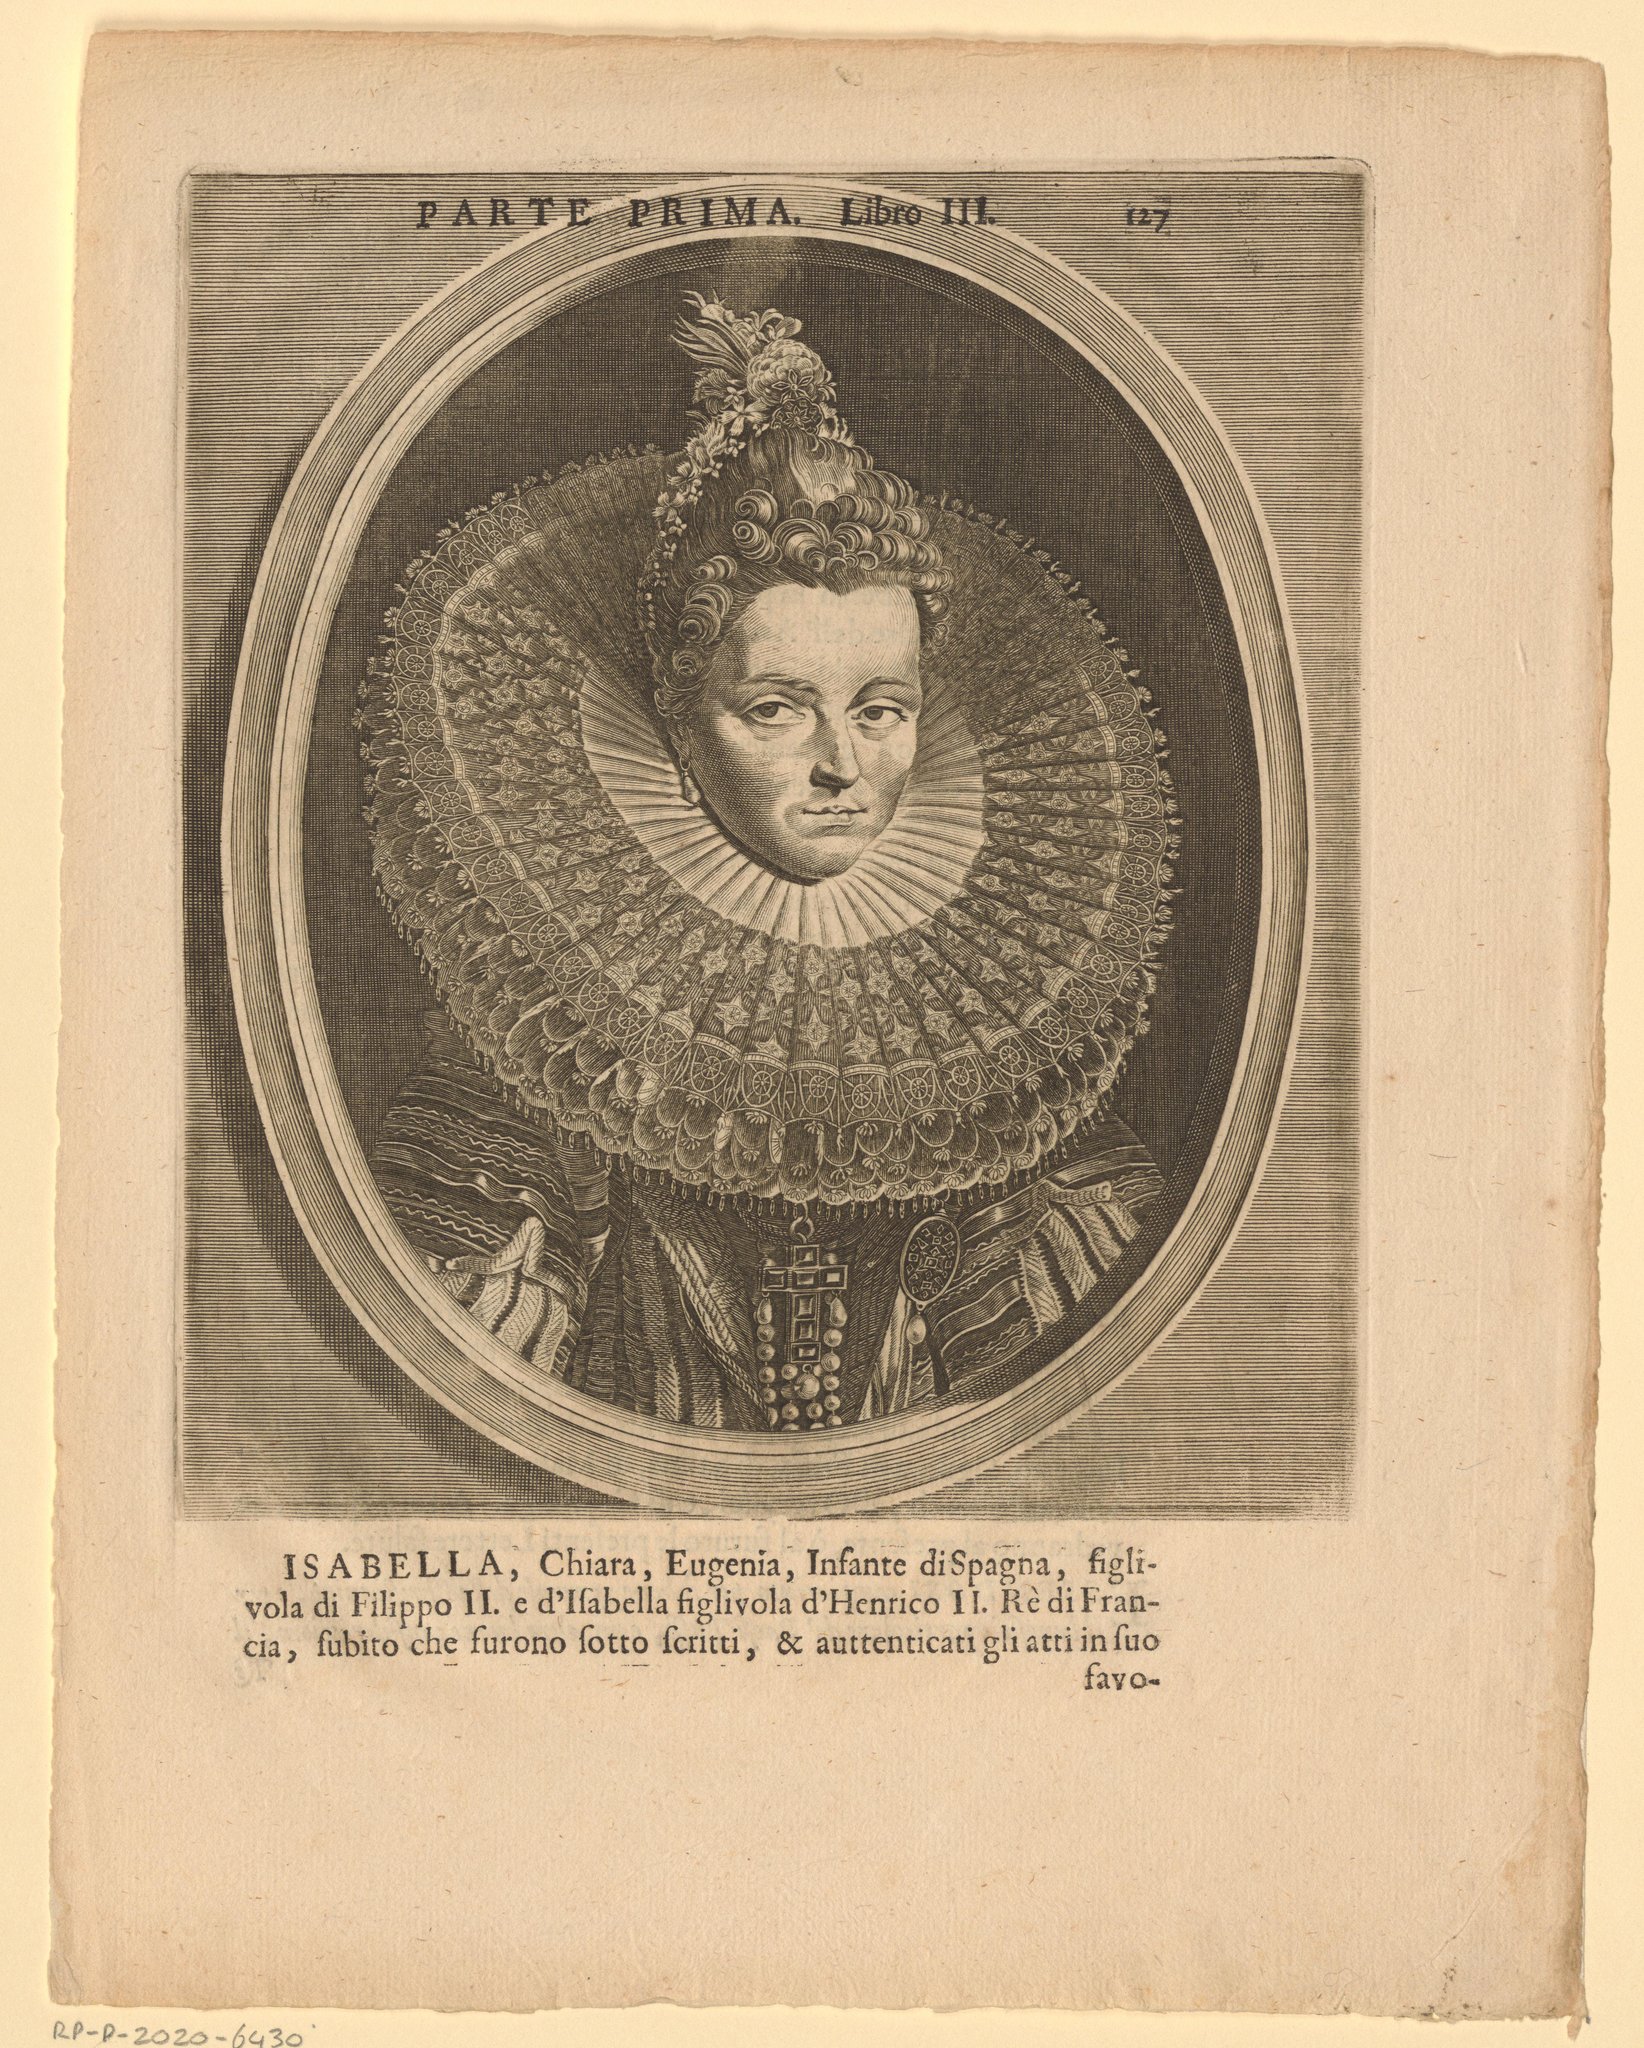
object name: book illustration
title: Portret van Isabella Clara Eugenia, infante van Spanje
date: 1690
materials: paper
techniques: engraving, letterpress printing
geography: amsterdam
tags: infante van spanje isabella clara eugenia, historical persons - bb - woman, ruler, sovereign - bb - female ruler, neck-gear: collar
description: Prent uit: Leti, Gregorio. Teatro Belgico, o vero ritratti historici (...). Amsterdam: Willem de Jonge, 1690, p. 127. Prent ook gebruikt in: Bor, Pieter. Oorsprongk, begin, en vervolgh der Nederlandsche oorlogen, beroerten (...). Amsterdam: weduwe Joannes van Someren et al.,1684. Latere staat van prent gebruikt in: Le Clerc, Jean. Geschiedenissen der Vereenigde Nederlanden (...). Amsterdam: Zacharias Chatelain, 1730.